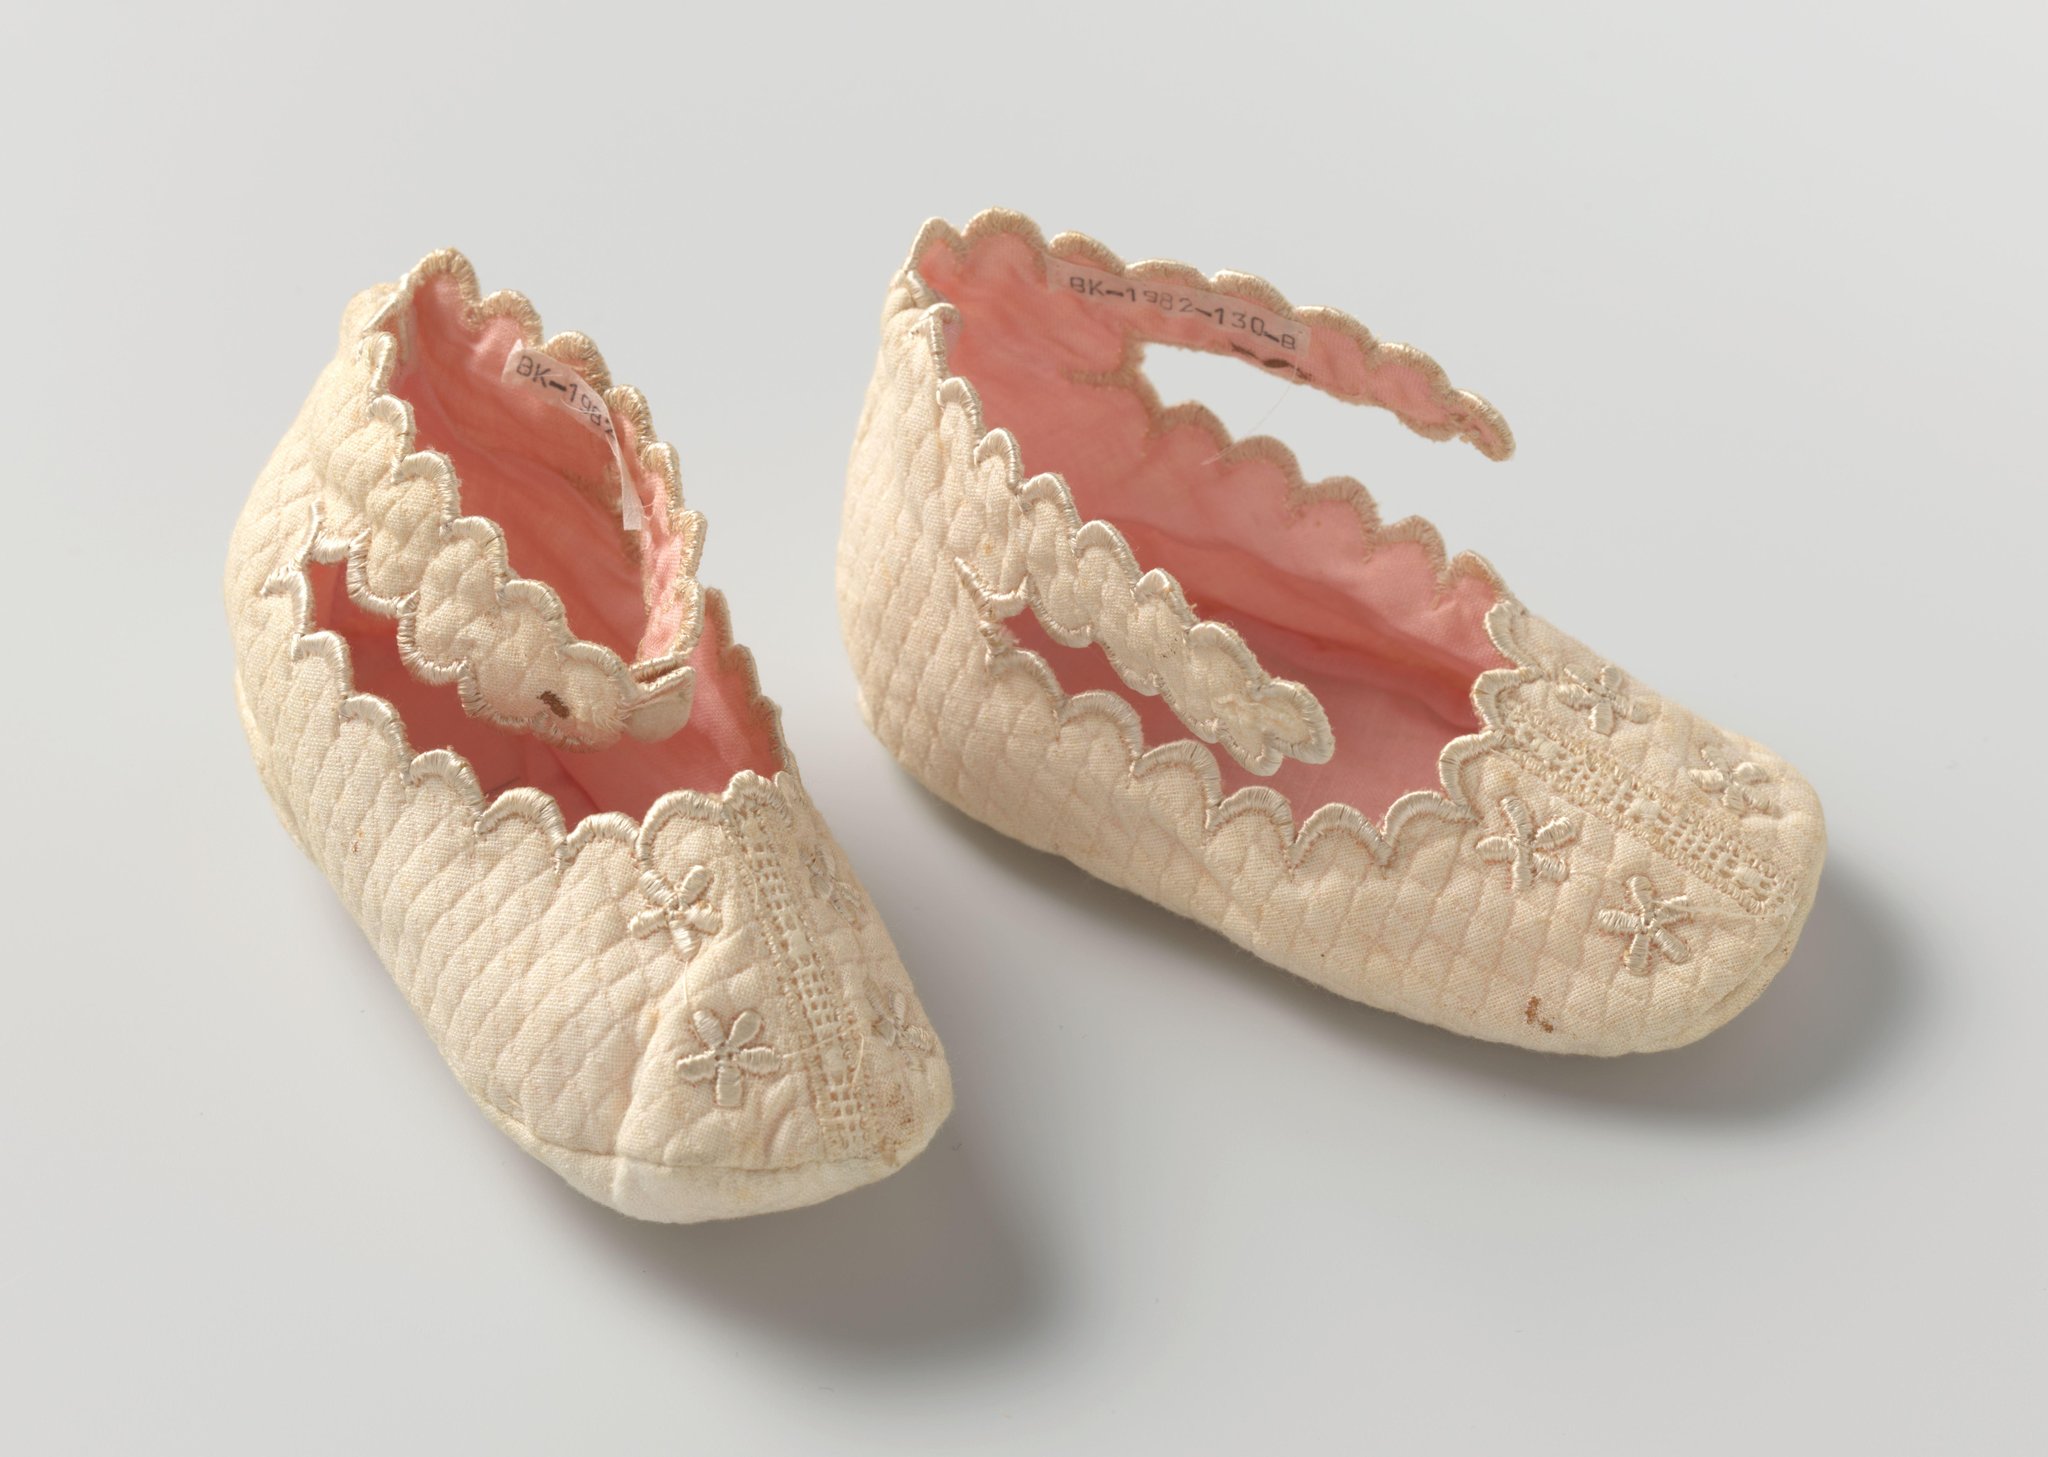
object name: childrenswear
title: Kinderslof van crèmekleurig wafelpiqué, geborduurd met beige zijden bloemetjes en afgezet met gefestonneerde schulpjes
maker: Anonymous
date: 1891-1892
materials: cotton, linen, velvet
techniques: embroidered, weave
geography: dutch east indies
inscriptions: inscription: ‘19’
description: Kinderslof van crèmekleurig wafelpiqué, geborduurd met zijden bloemetjes en afgezet met gefestonneerde schulpjes. Model: plat, uitgesneden voorblad, hoge hiel met twee bandjes die middenvoor sluiten d.m.v. een fluwelen knoopje, gevoerd met roze linnen. Versiering: midden op de neus een geborduurde verticale band met aan weerszijden twee geborduurde bloemetjes. De schulprandjes zijn gefestoneerd met zijde.